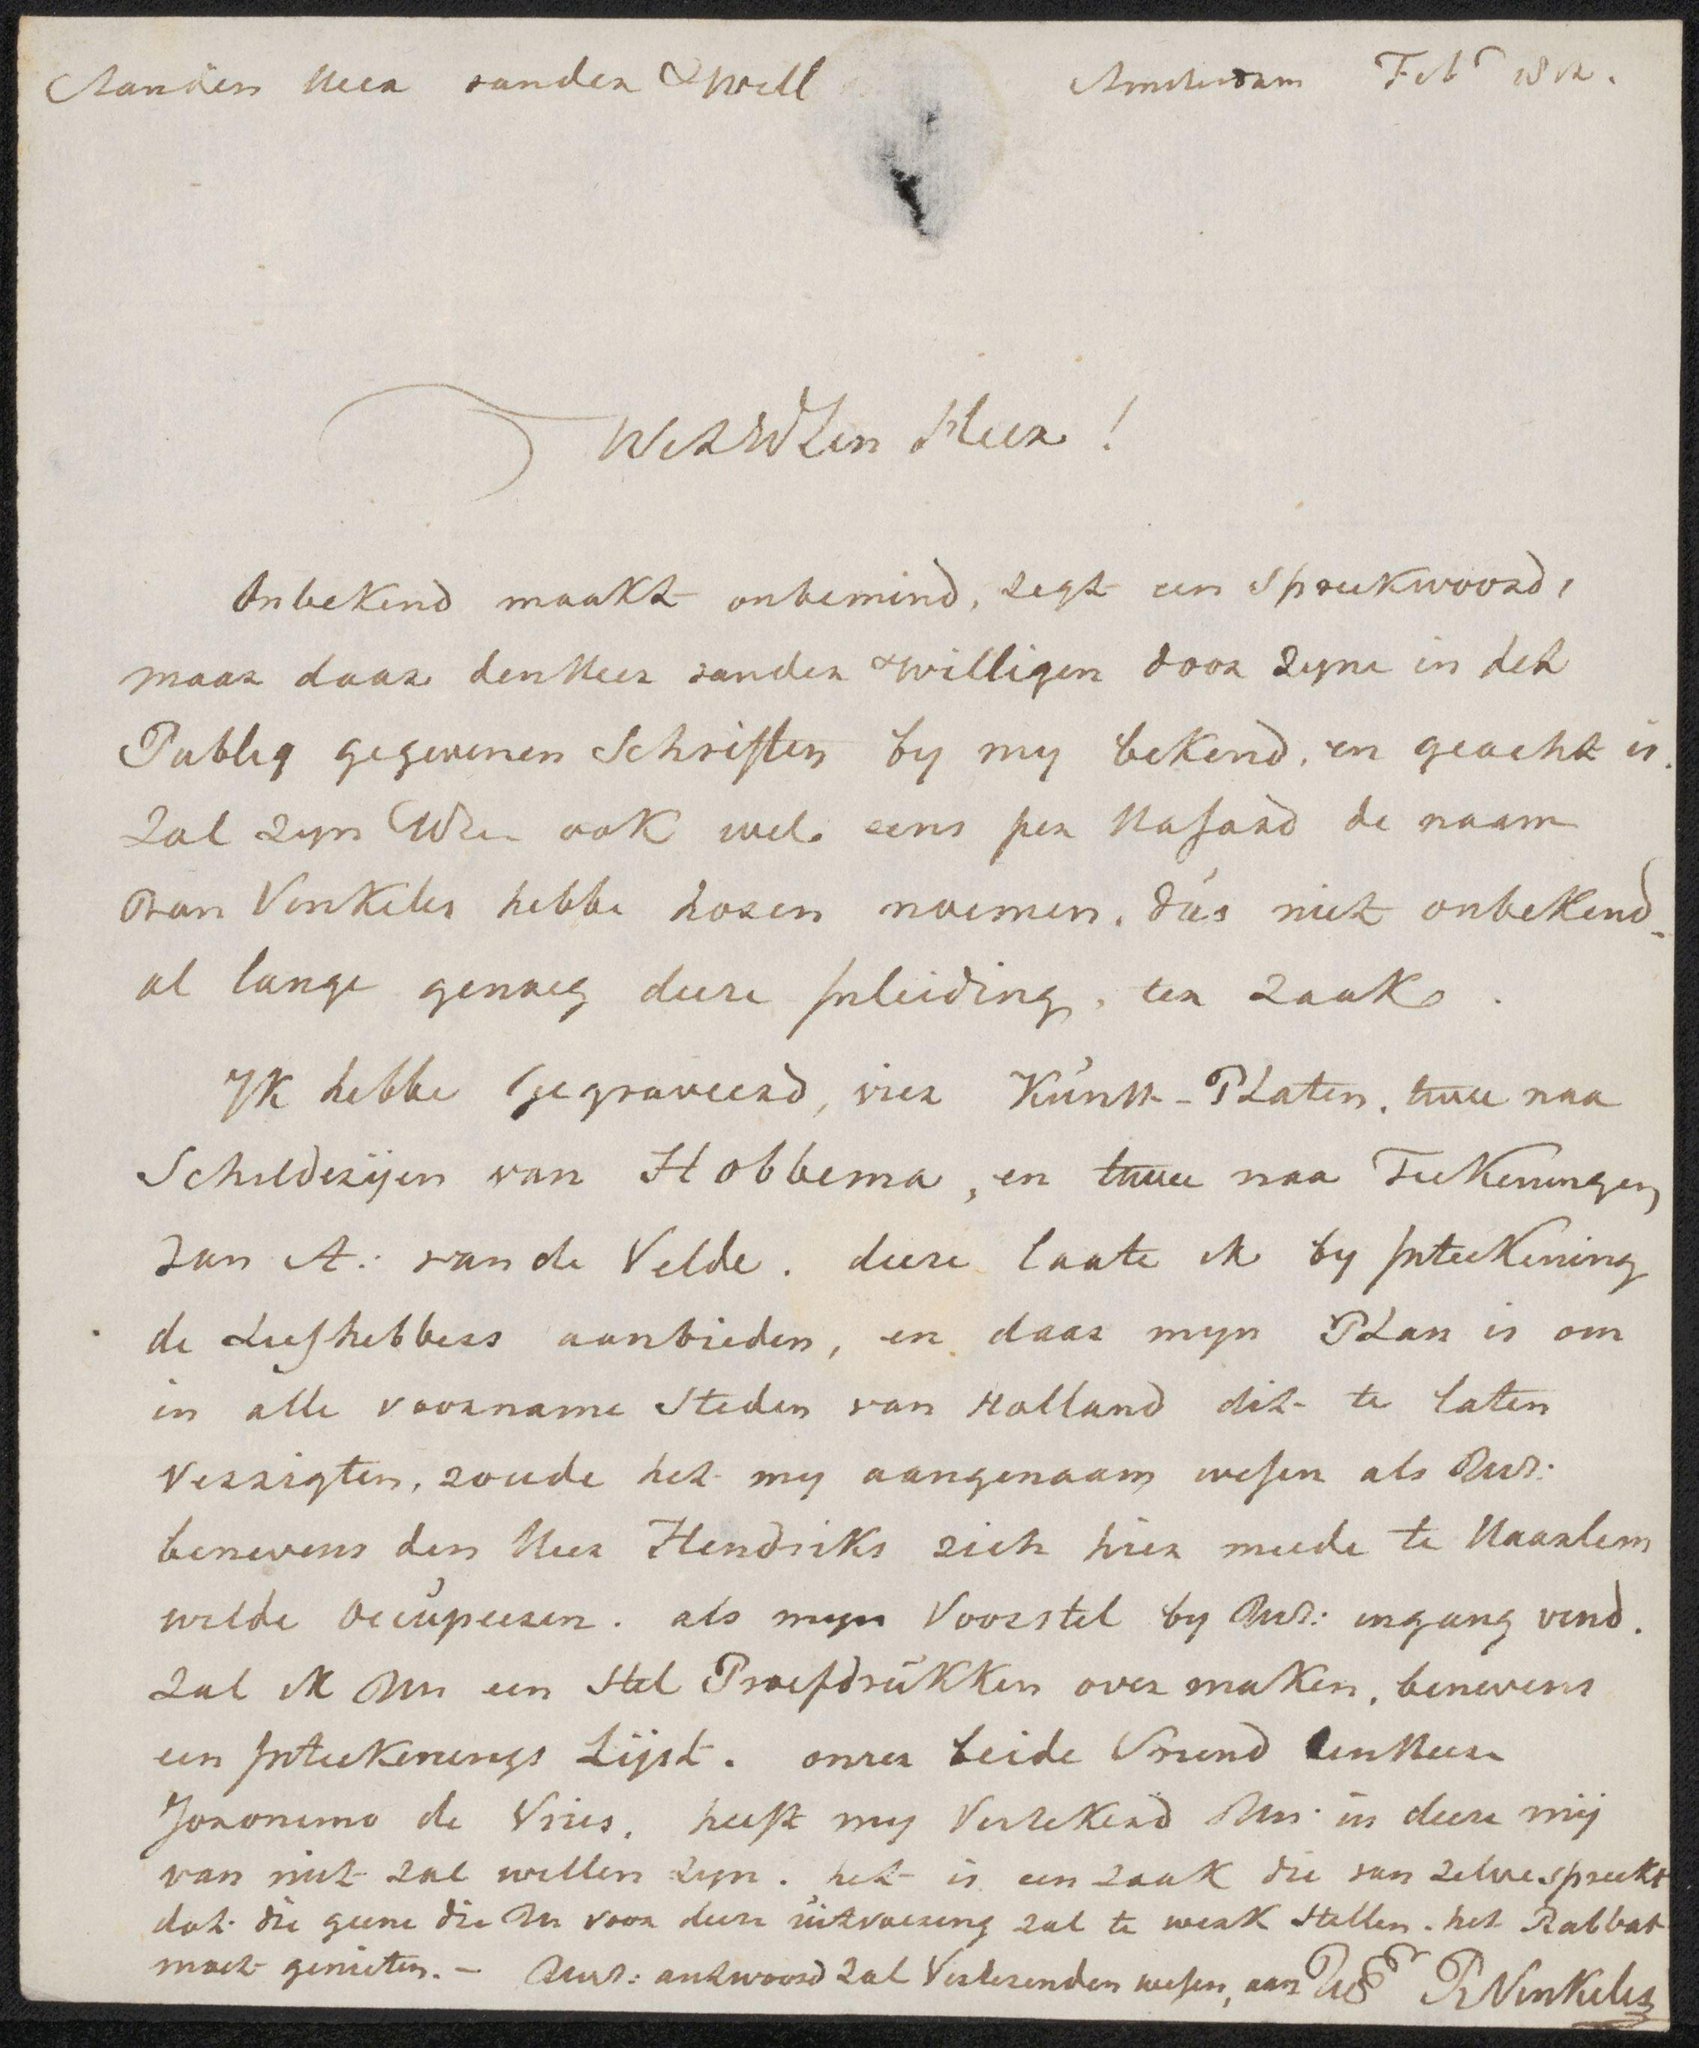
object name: letter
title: Brief aan Adriaan van der Willigen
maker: reinier vinkeles (i)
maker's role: draughtsman, print maker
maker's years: 1741-1816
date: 1802-1812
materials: ink, paper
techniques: pen, writing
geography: amsterdam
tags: jeronimo de vries, amsterdam, painter, print maker, adriaen van de velde, meindert hobbema, rotterdam, haarlem, draughtsman, adriaan van der willigen, drawing, the graphic arts, painting (including book-illumination, miniature-painting)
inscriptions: watermark